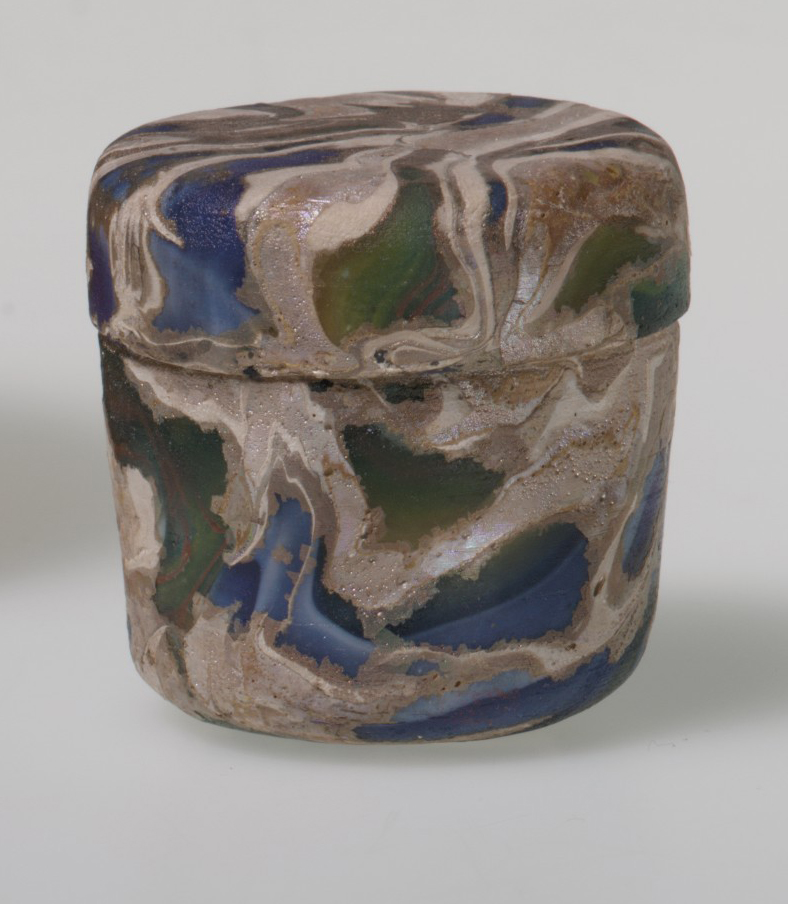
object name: pyxis with lid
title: Glass mosaic pyxis with lid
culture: roman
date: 1-50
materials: glass